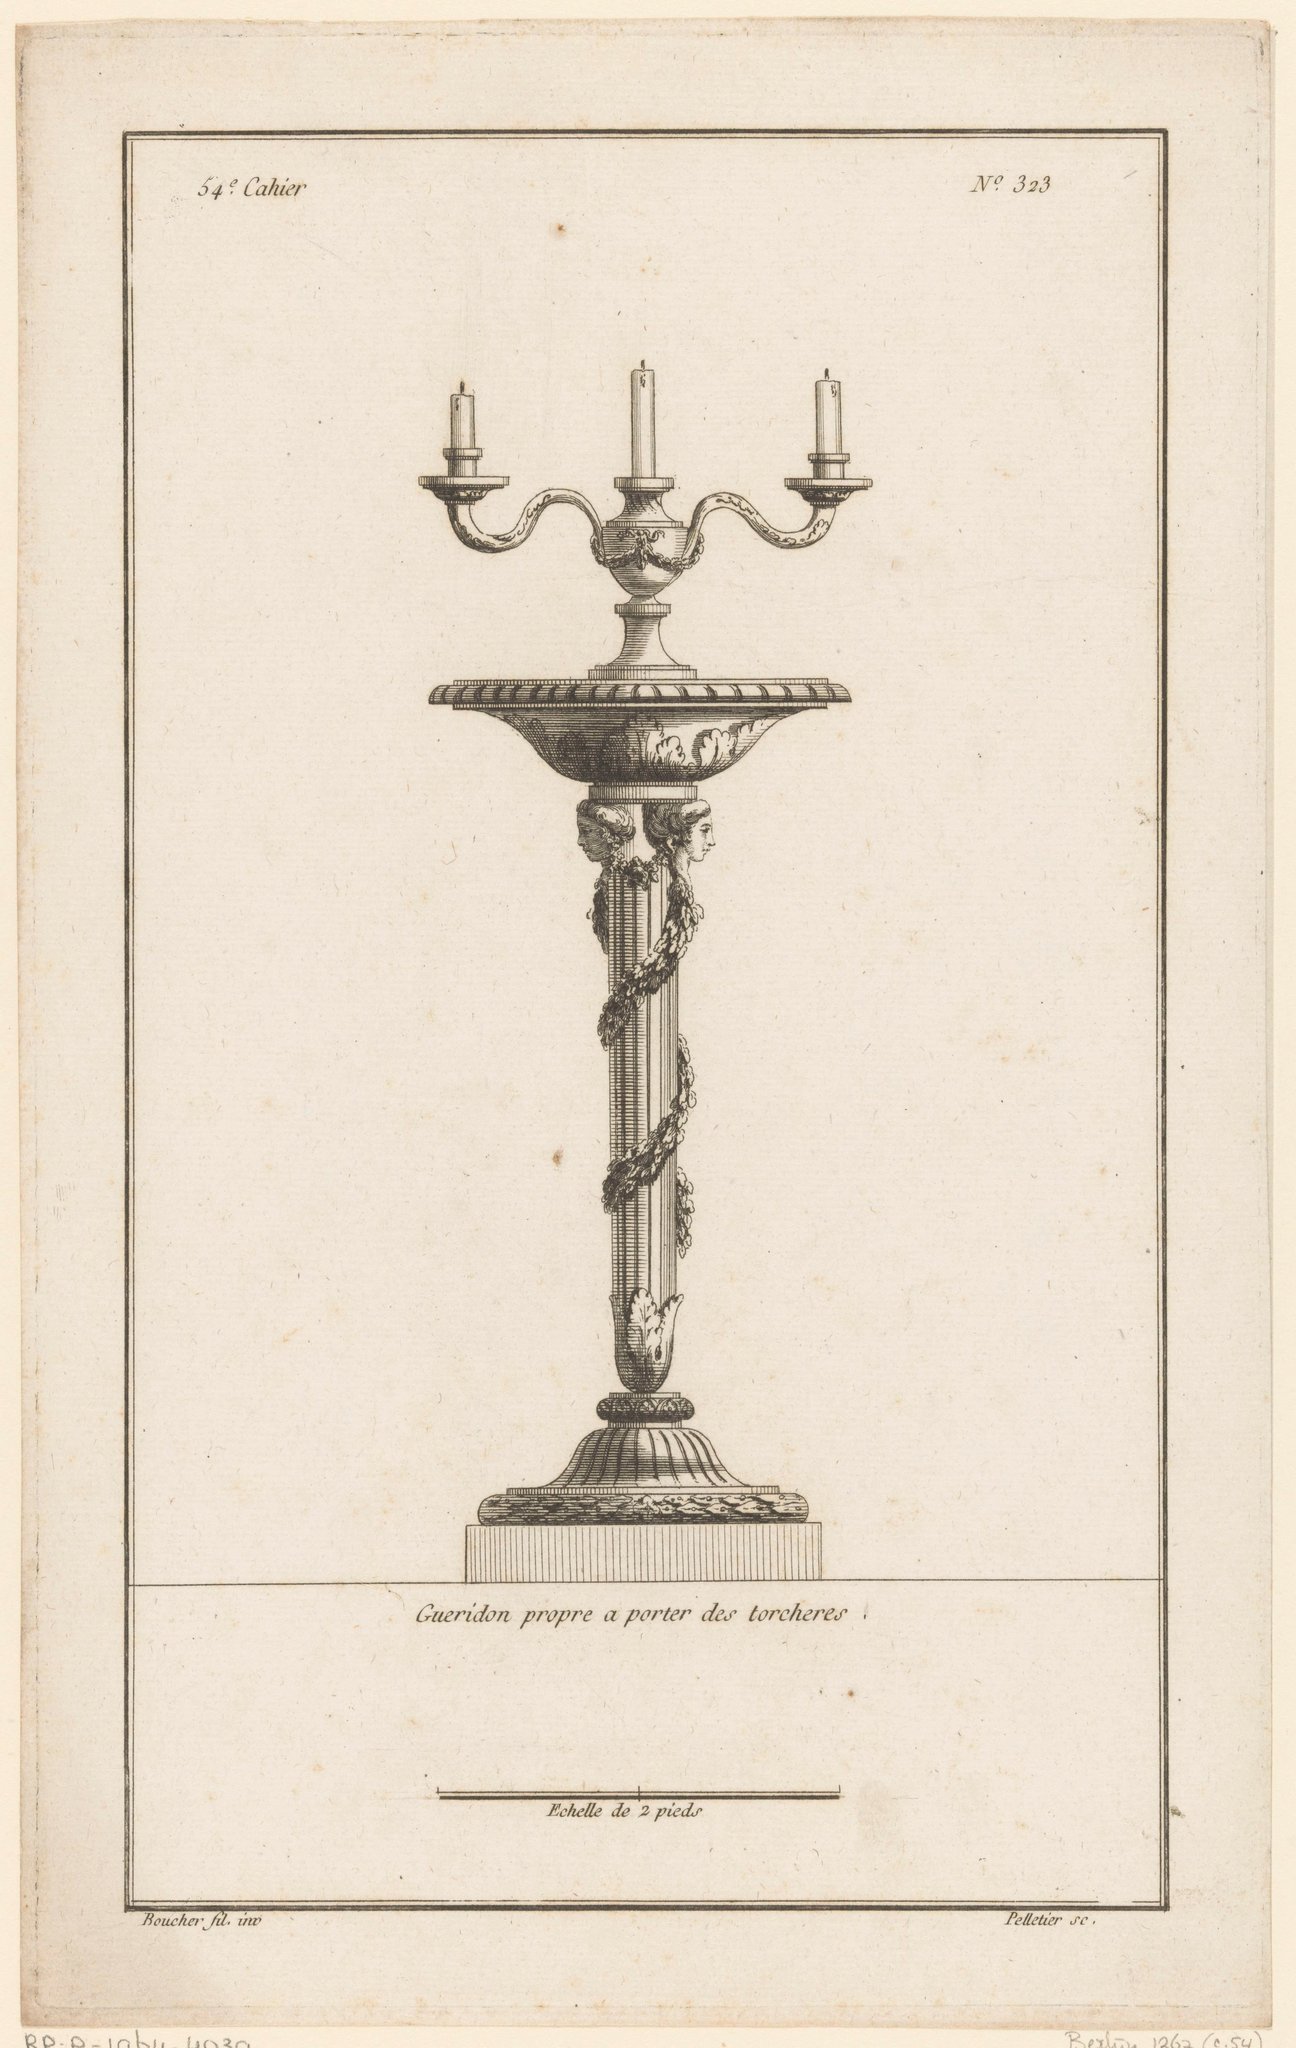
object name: ornament print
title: 54e Cahier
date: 1772-1779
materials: paper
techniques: engraving, etching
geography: paris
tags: face, chandelier, candelabrum, table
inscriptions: collector's mark: Lugt 2760, collector's mark: Lugt 2228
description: Een gueridon met een driearmige kandelaar en twee vrouwelijke gezichten. Prentnummer 323.